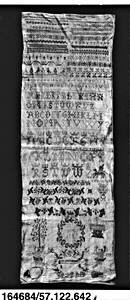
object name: sampler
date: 1767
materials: linen, silk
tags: wreaths